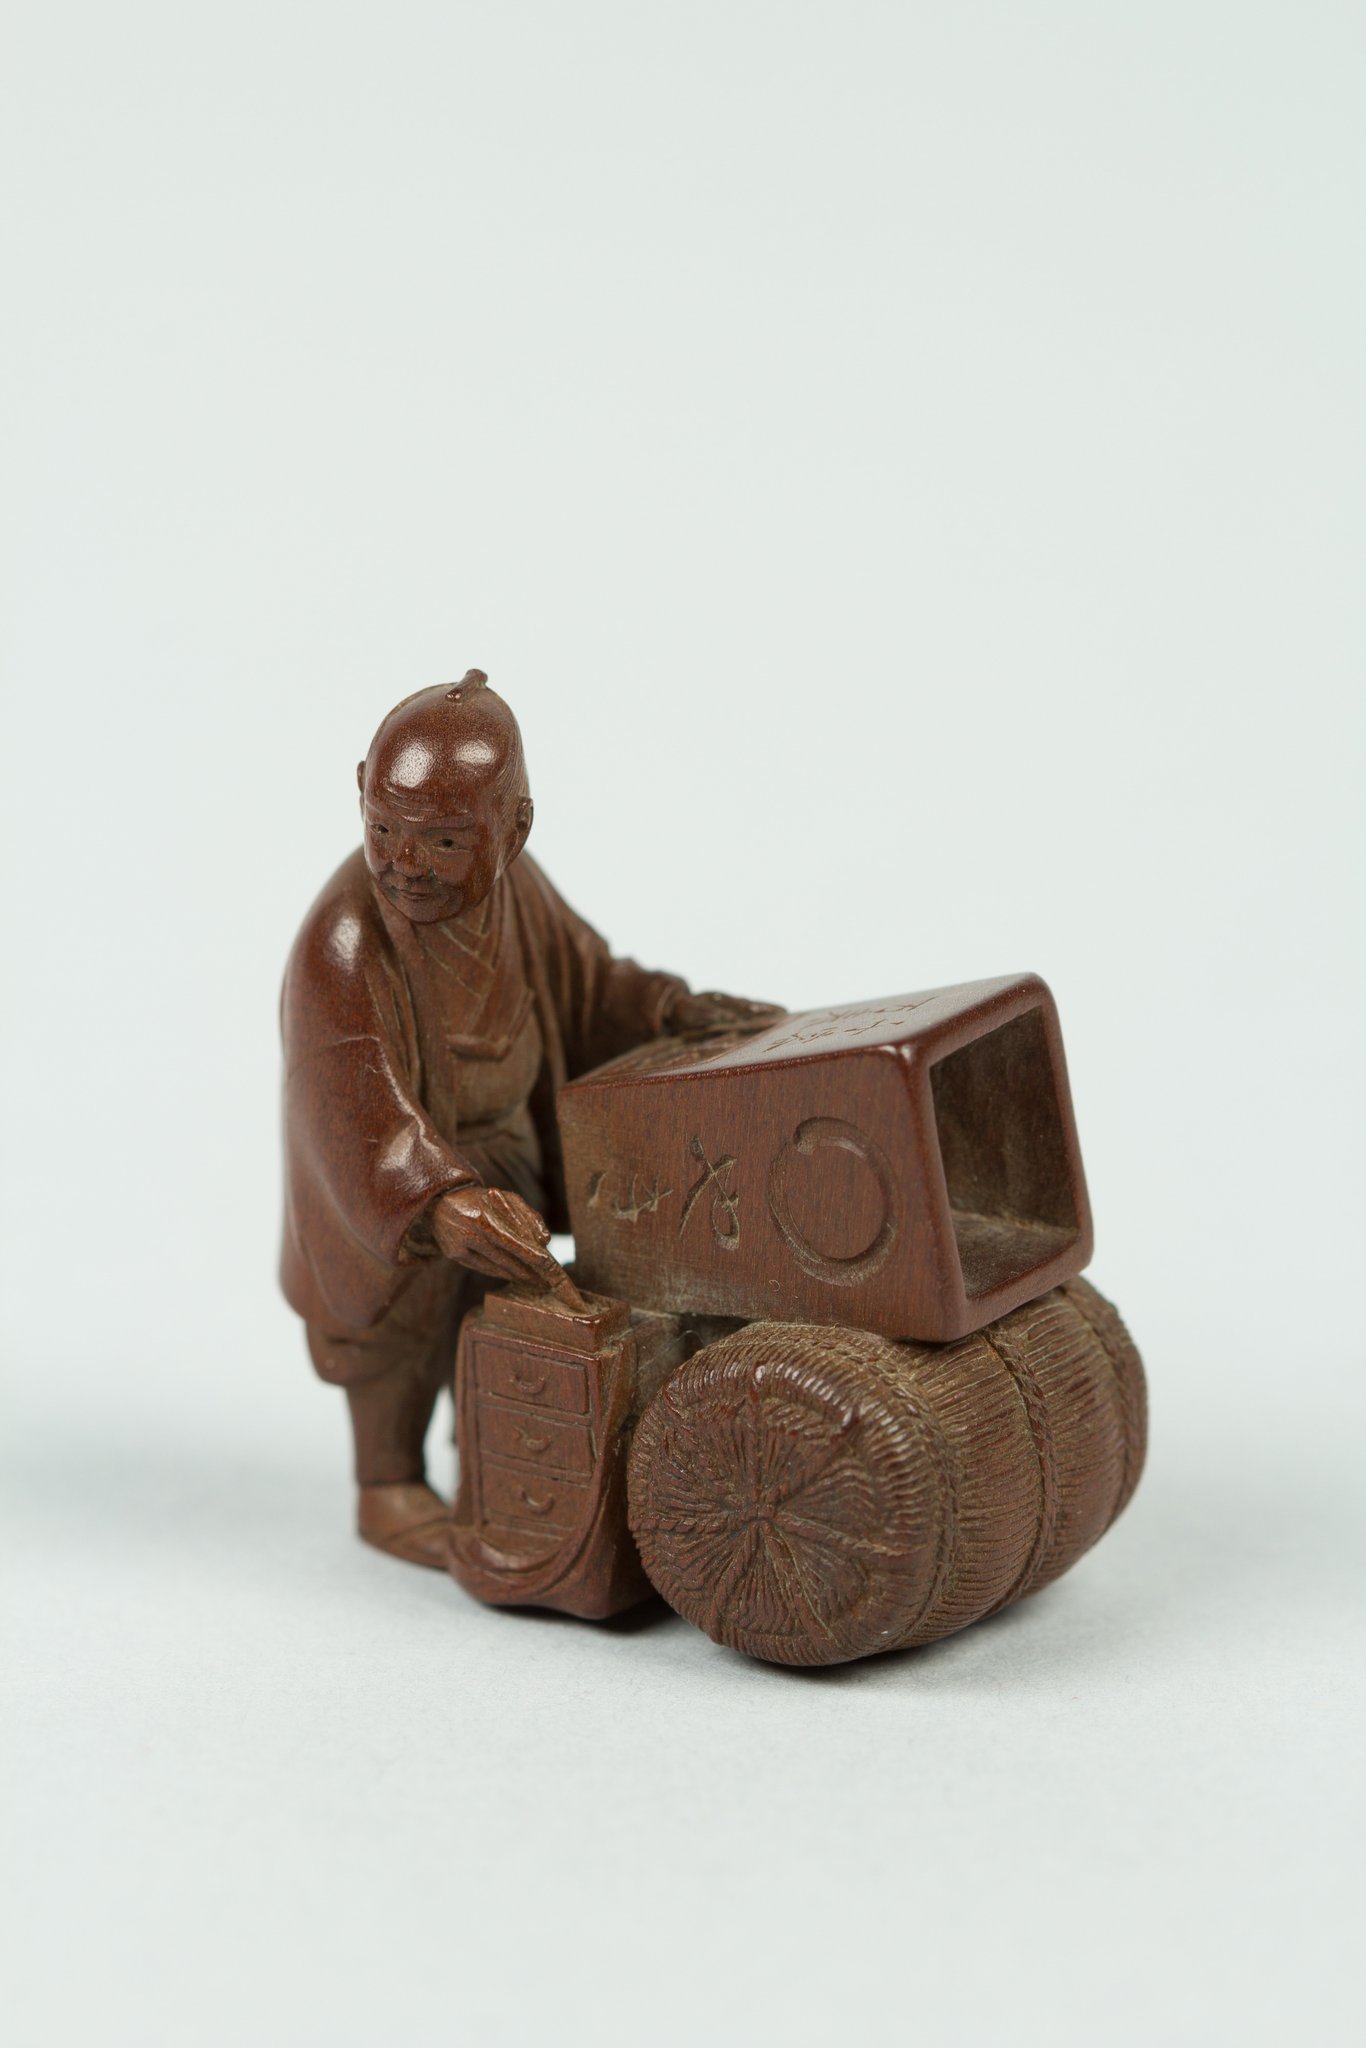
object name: netsuke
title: Netsuke of Artist Marking a Box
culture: japanese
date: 1801-1900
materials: wood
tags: men